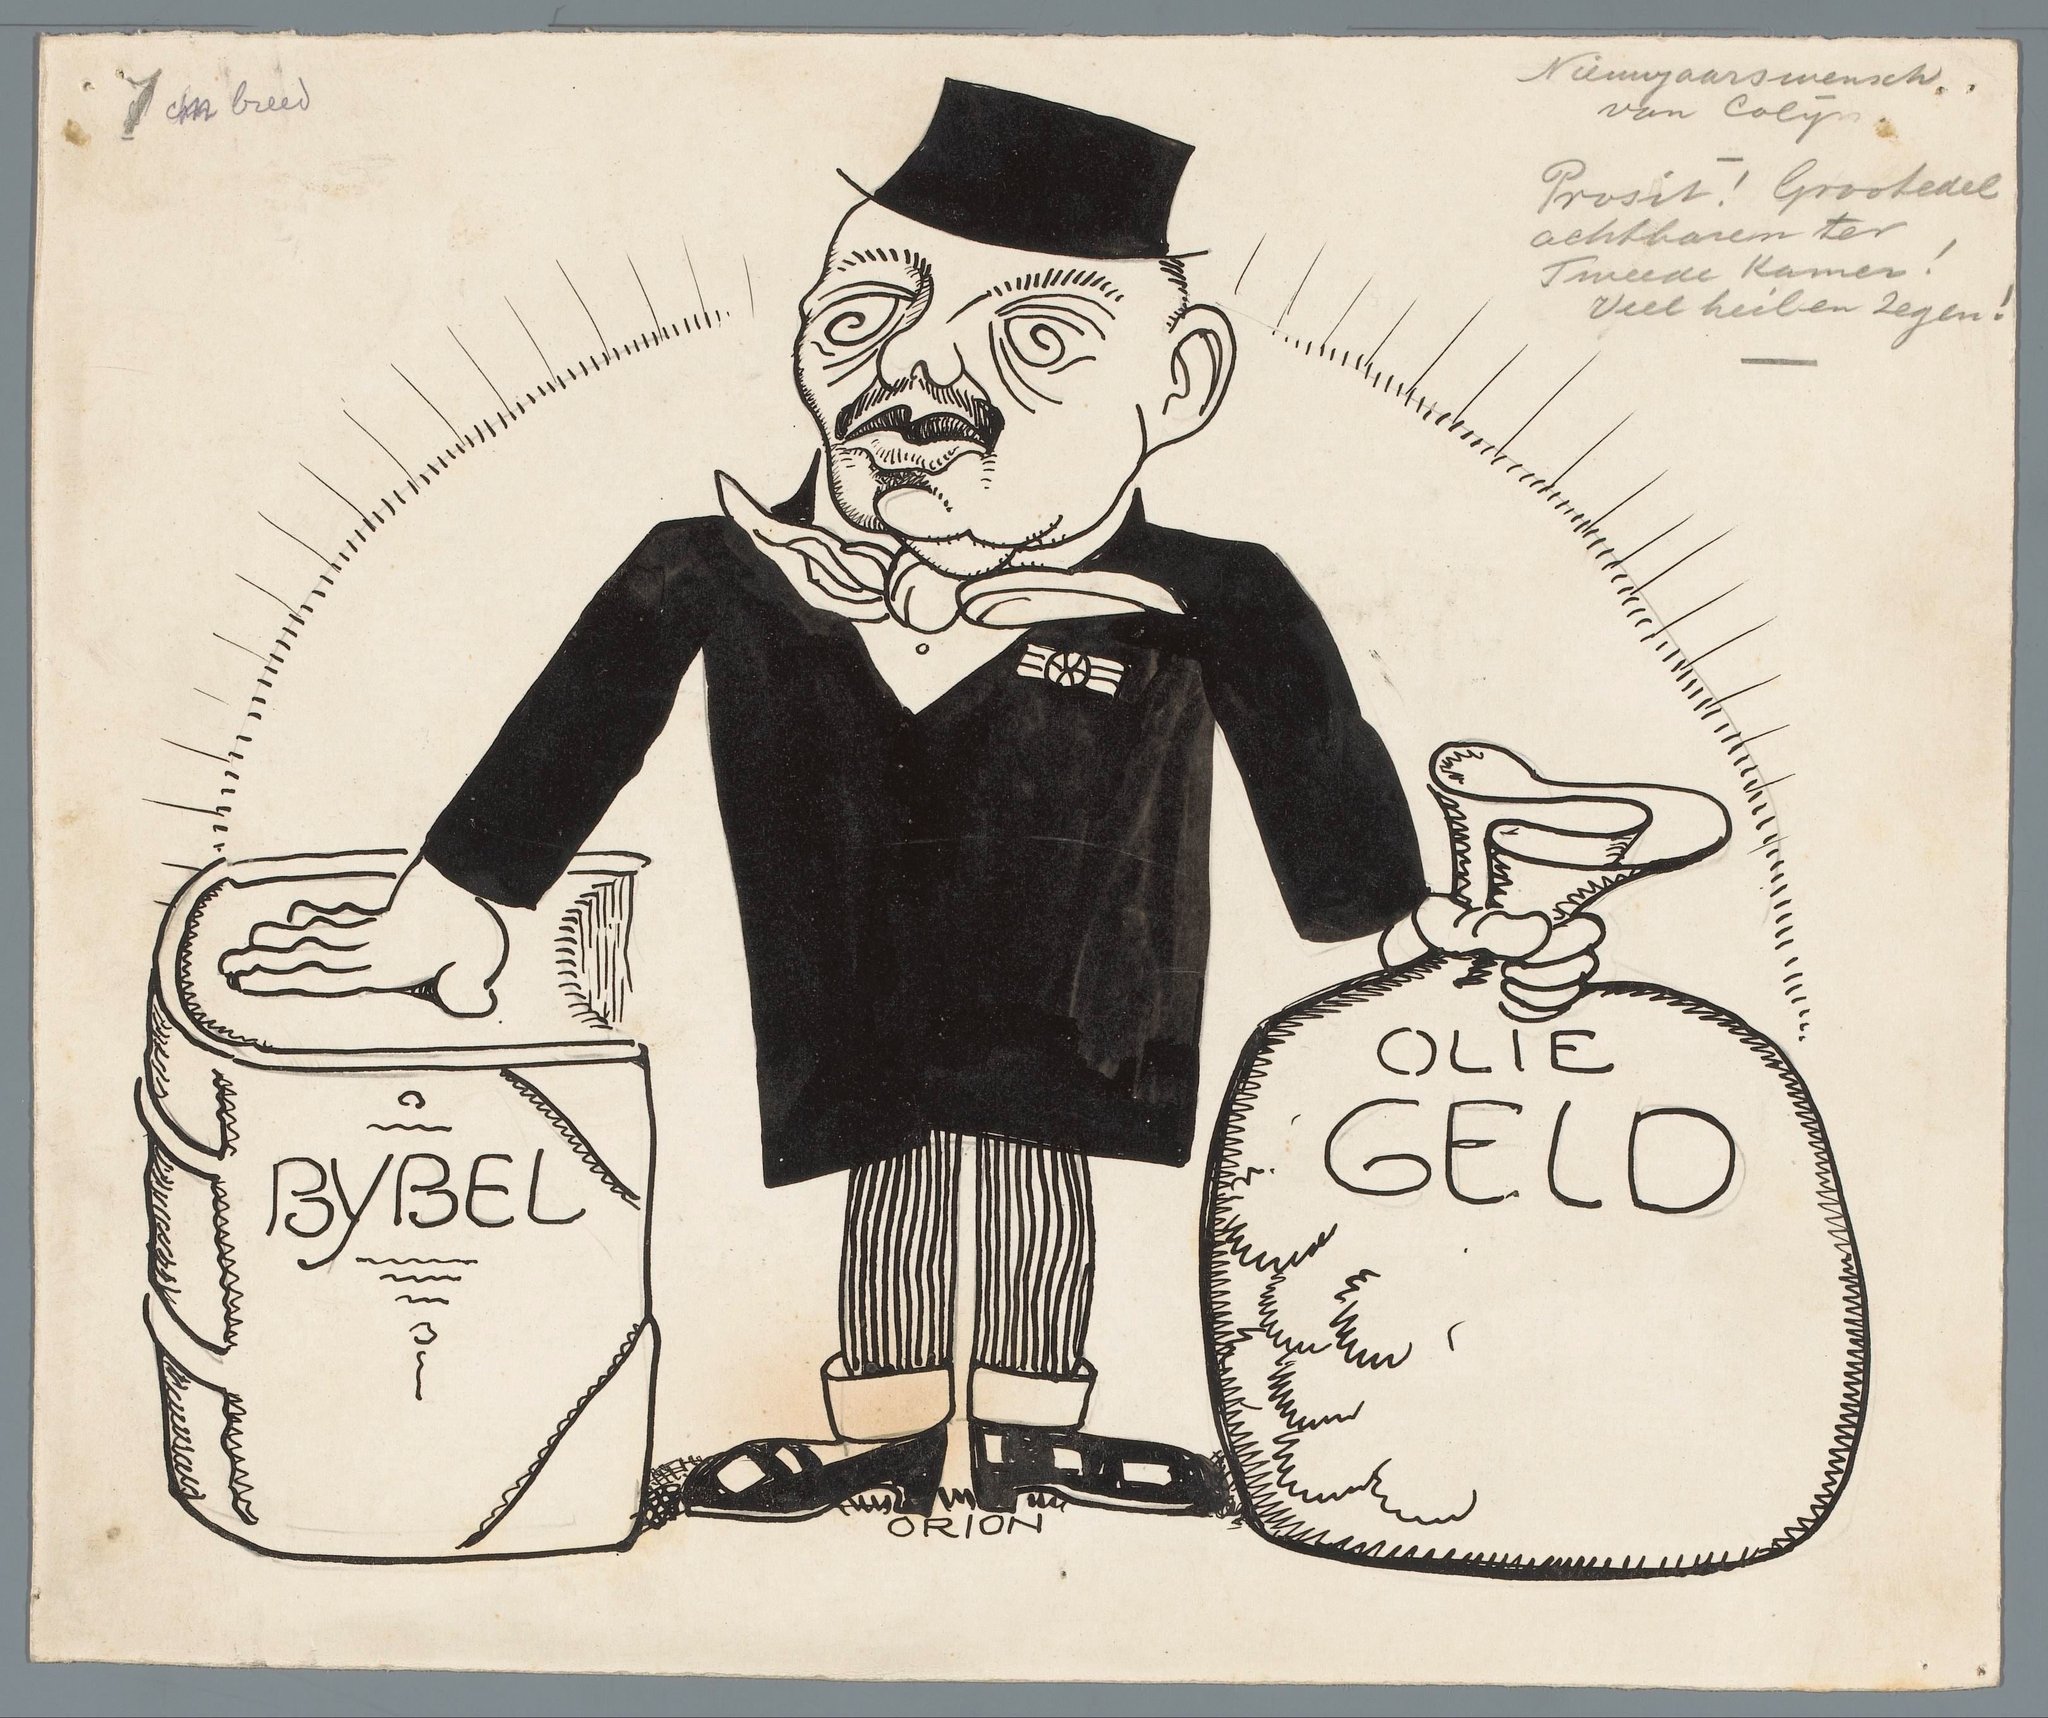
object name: cartoon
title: Nieuwjaarswens van Colijn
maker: patricq kroon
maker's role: draughtsman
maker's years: 1862-1941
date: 1900-1935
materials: ink, paper, pencil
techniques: brush, pen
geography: netherlands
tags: hendrikus colijn, the bible as a book, political caricatures and satires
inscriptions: inscription: ‘Nieuwjaarswensch van Colijn - Proost! Grootedel achtbaren ter Tweede Kamer! Veel heil en zegen!’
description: H. Colijn met één hand op de Bijbel, in de andere hand een zak 'oliegeld'. Ontwerp voor een politieke spotprent.